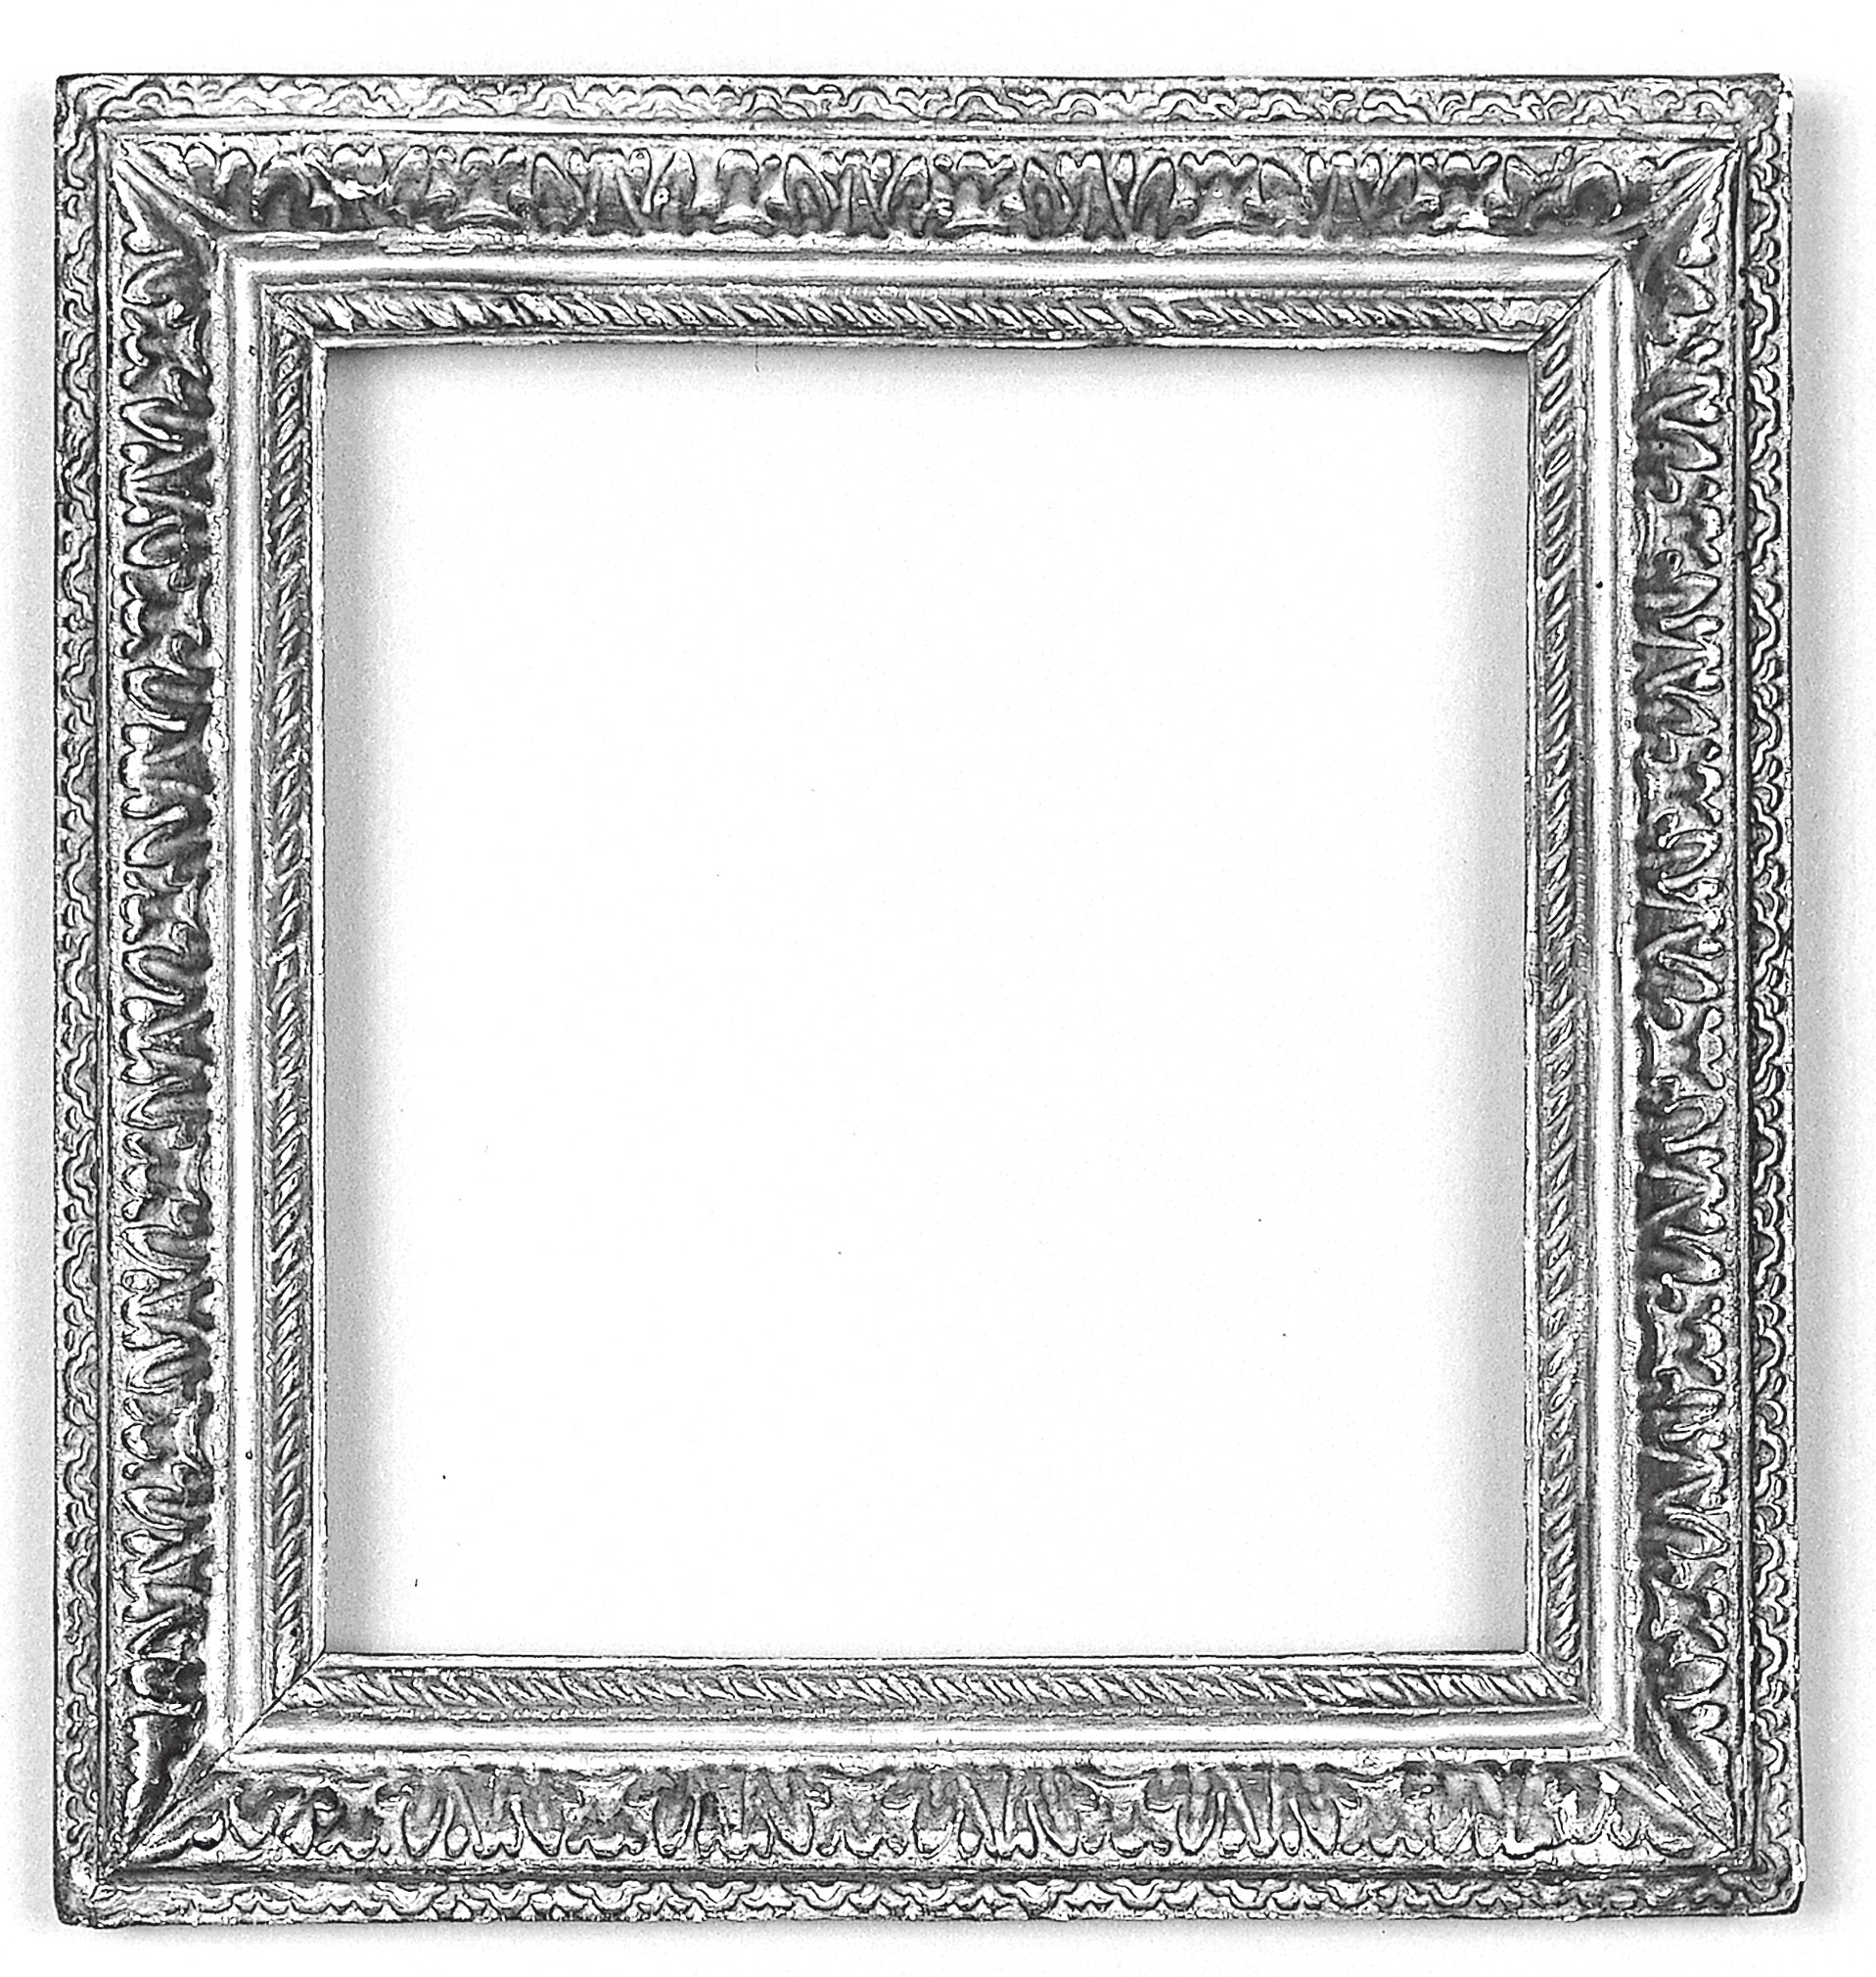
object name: frame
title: Ovolo frame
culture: french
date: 1640-1650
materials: wood